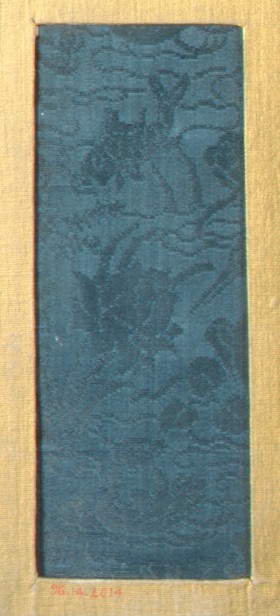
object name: piece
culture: chinese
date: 1701-1900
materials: silk